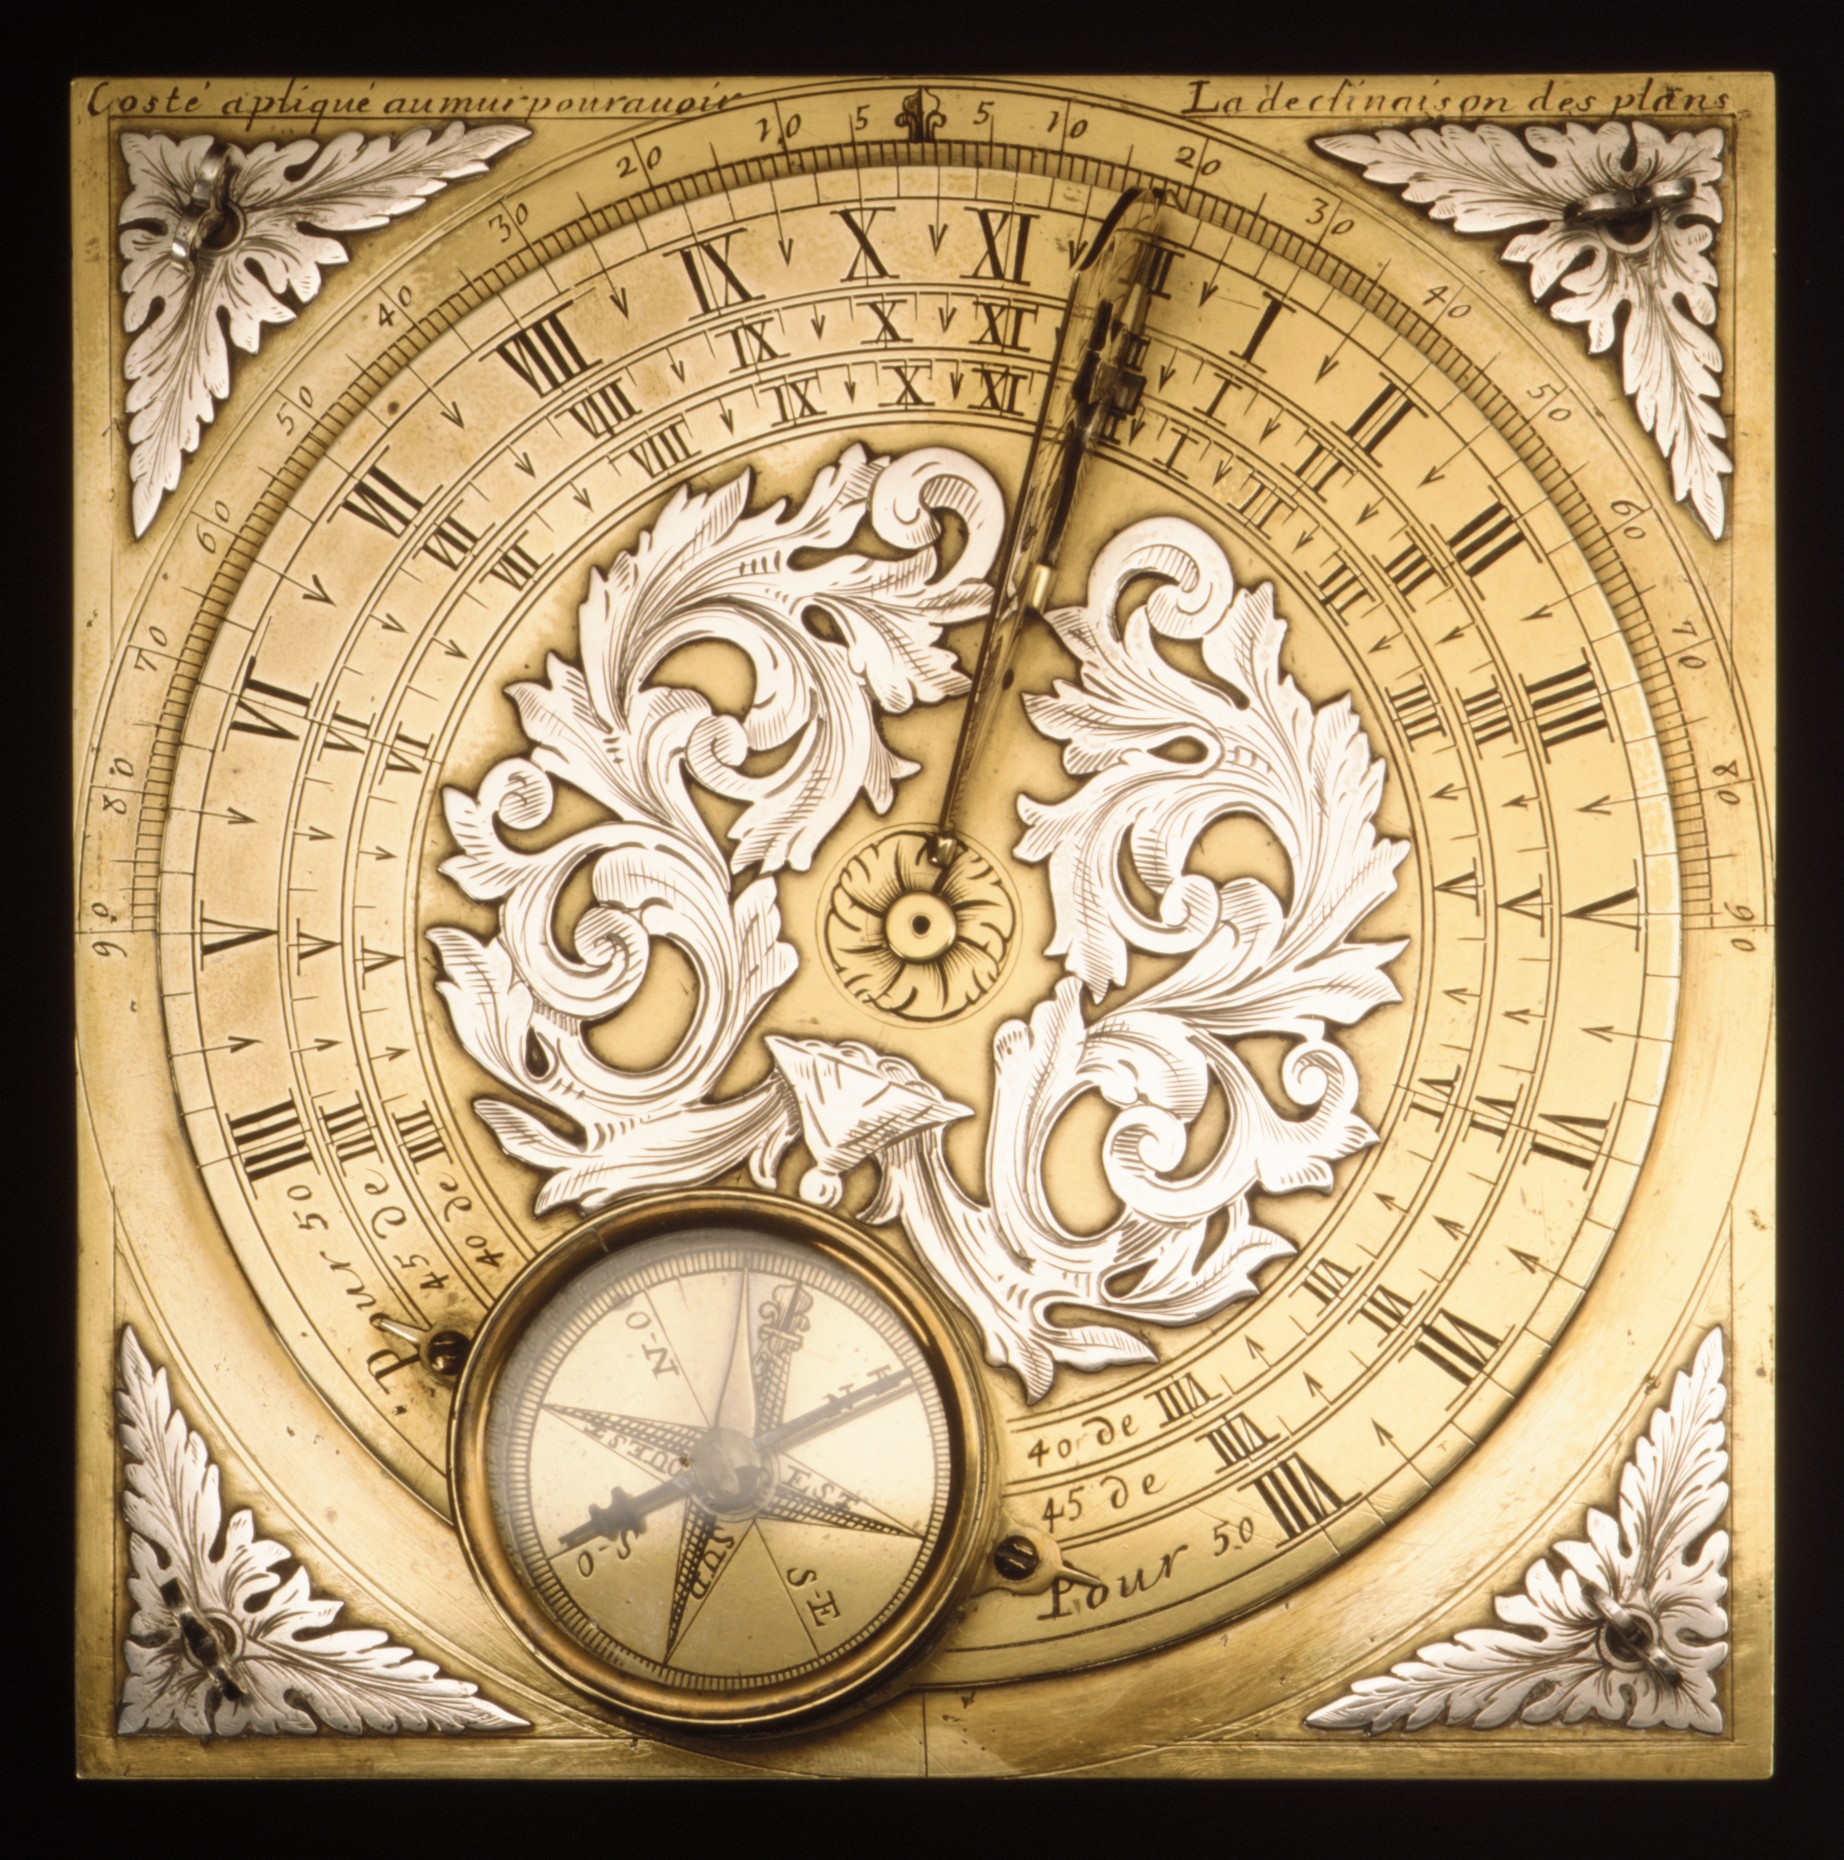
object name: sundial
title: Combination portable sundial and instrument for calibrating sundials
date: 1690-1710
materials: brass, silver